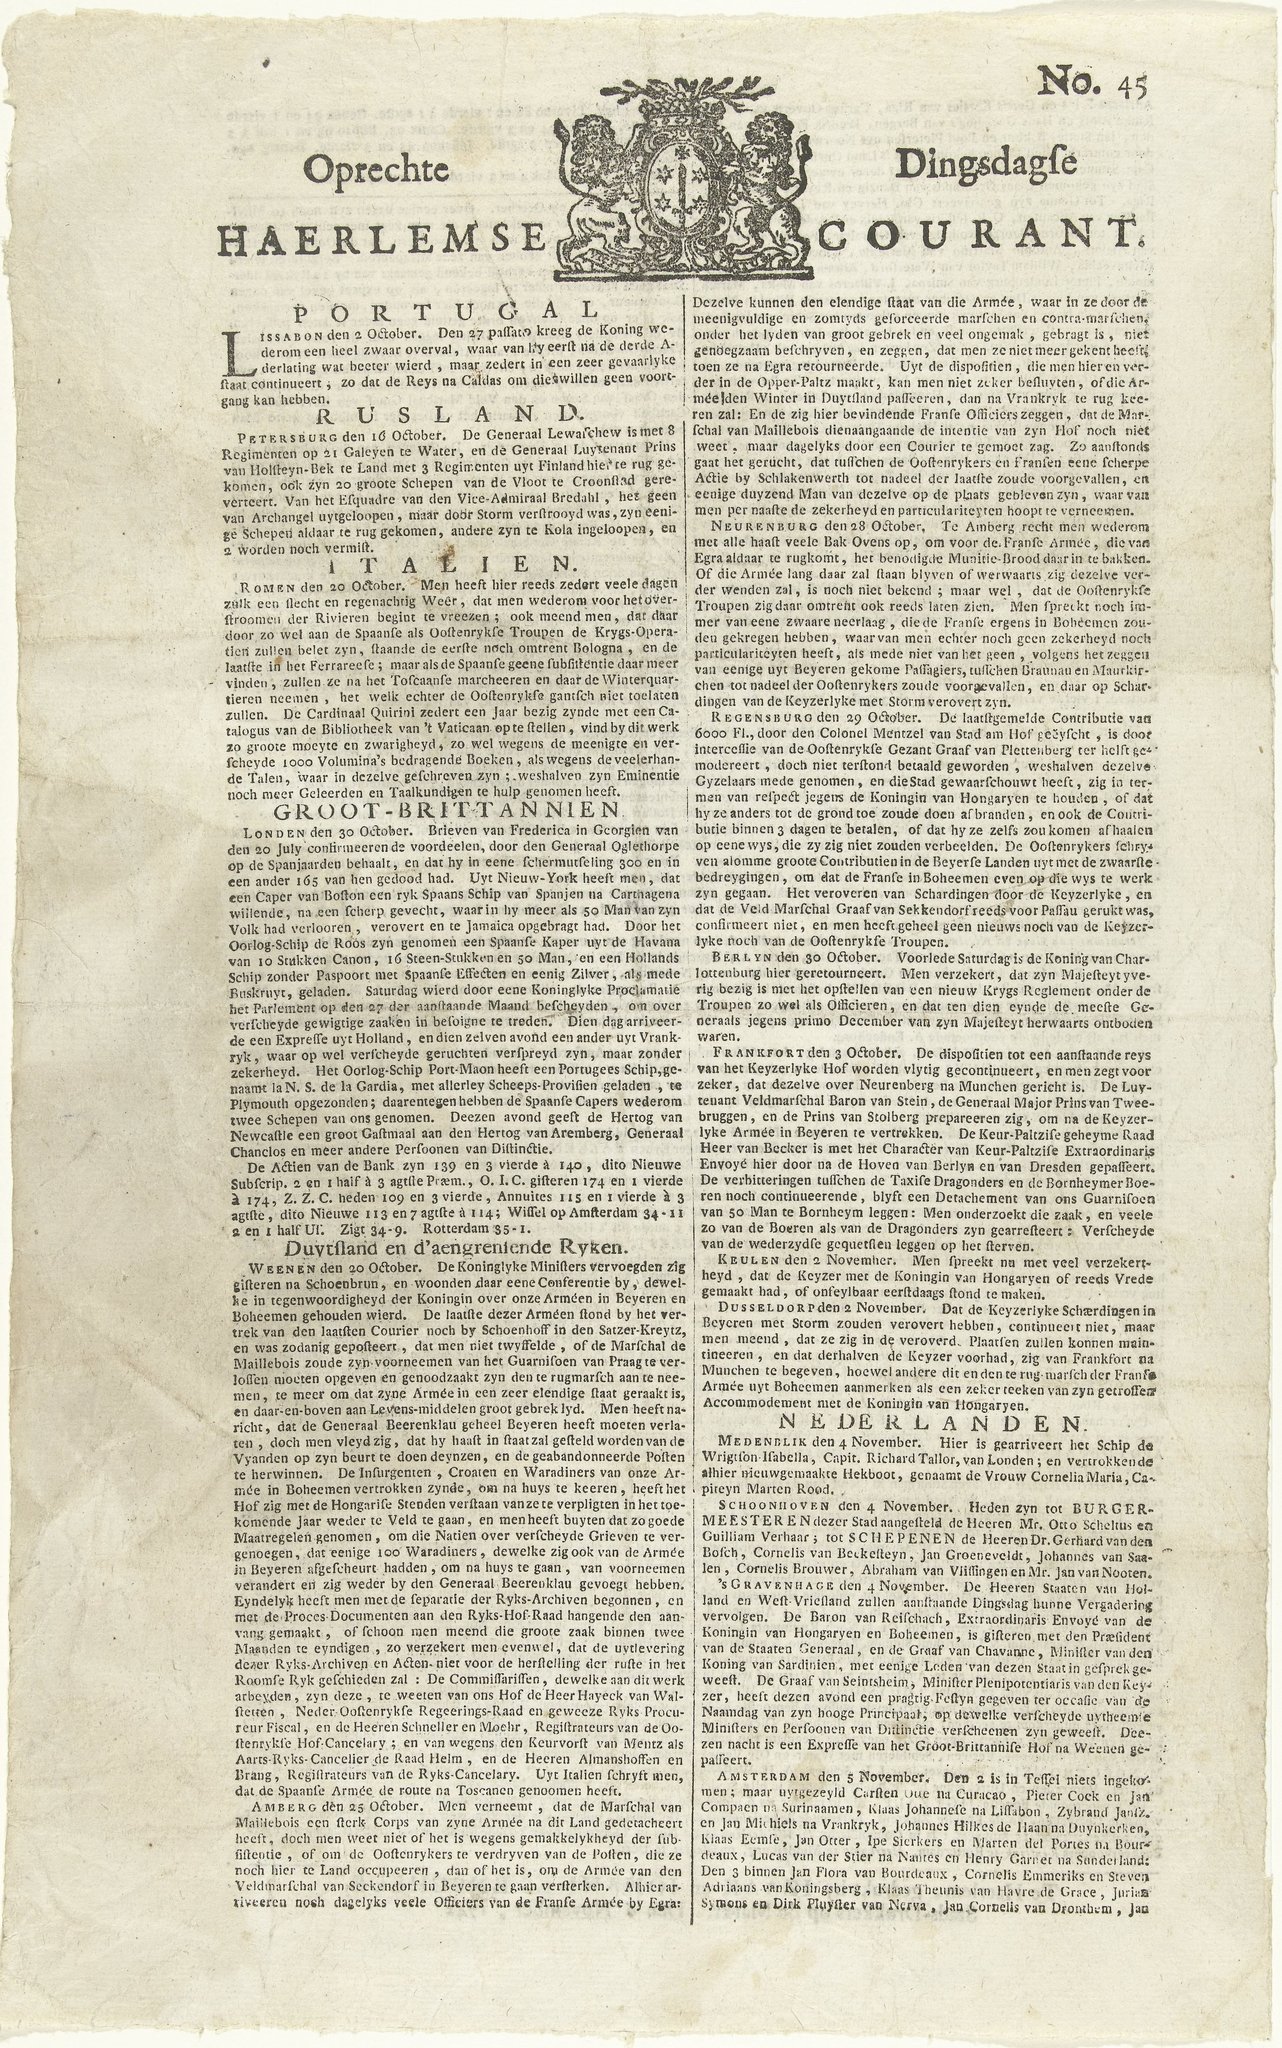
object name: newspaper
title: Oprechte Haerlemse Courant, 1742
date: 1742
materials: paper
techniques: letterpress printing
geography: haarlem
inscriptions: collector's mark: Lugt 2228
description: Exemplaar van de krant getiteld: Oprechte Dingsdagse Haerlemse Courant, No. 45, editie van 6 november 1742. Bovenaan een vignet met het stadswapen van Haarlem. Op beide zjden bedrukt.